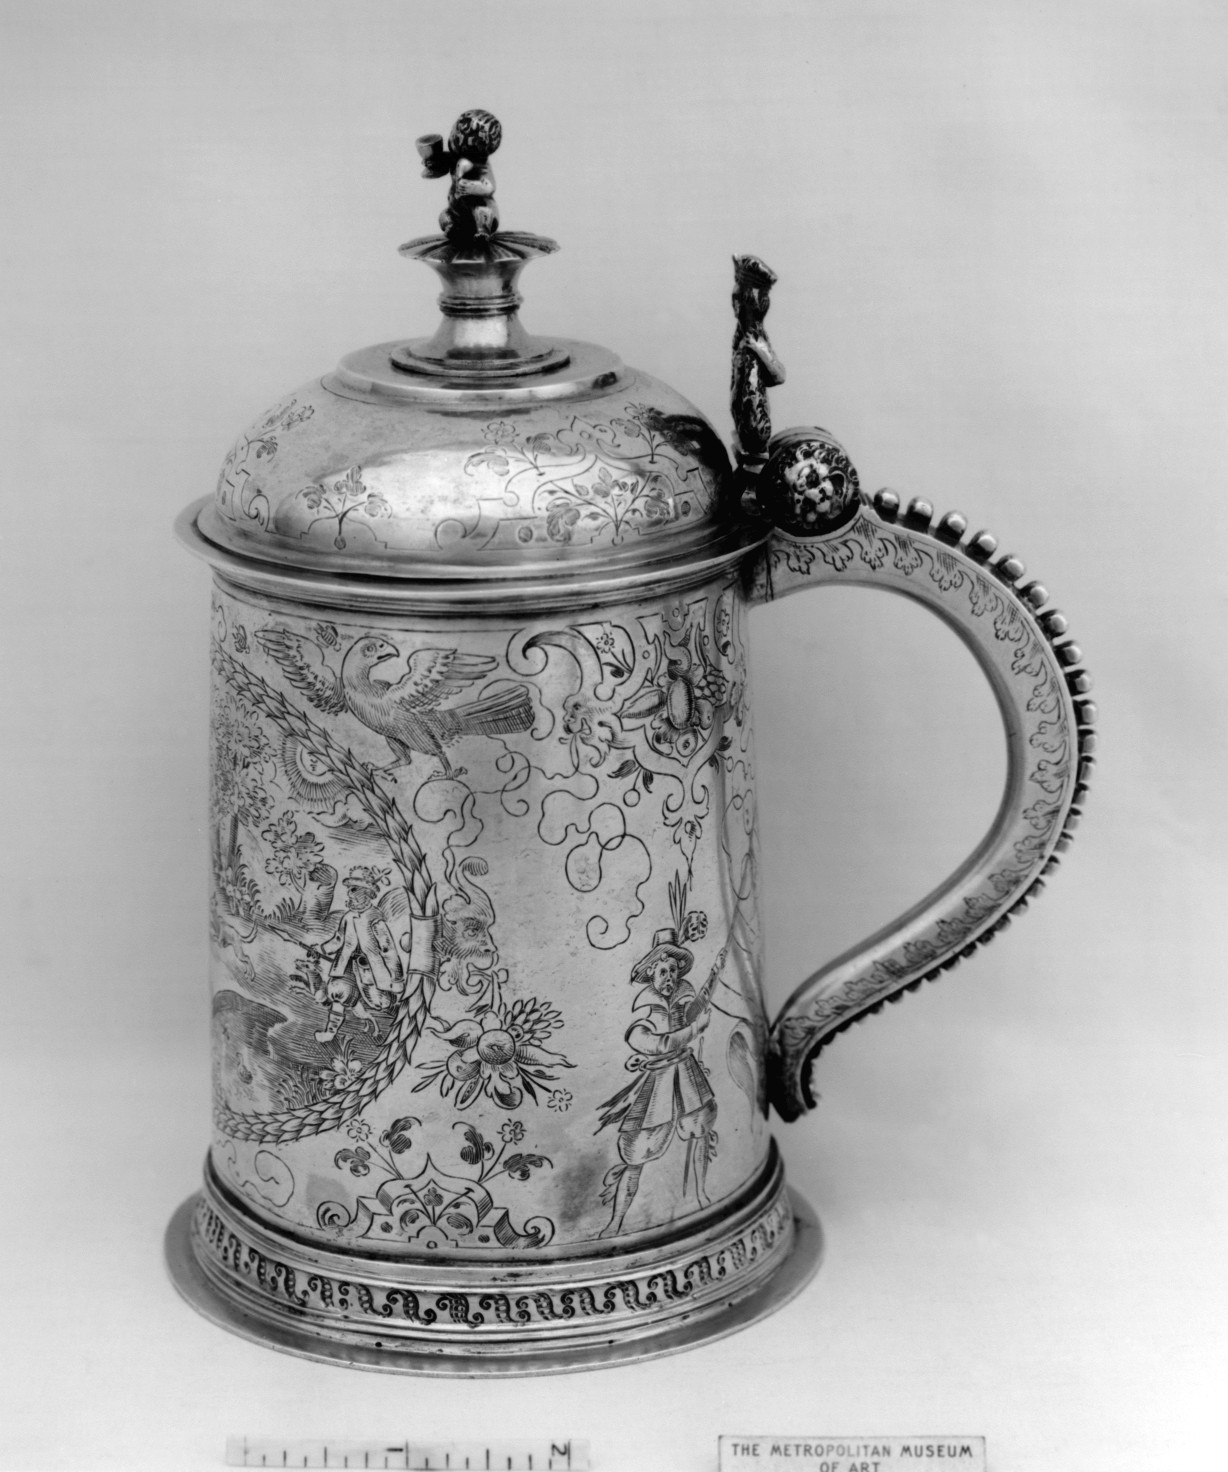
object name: tankard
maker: i. b. (austrian)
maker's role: maker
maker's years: 1600-1699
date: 1601-1633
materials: silver gilt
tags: birds,men,flowers